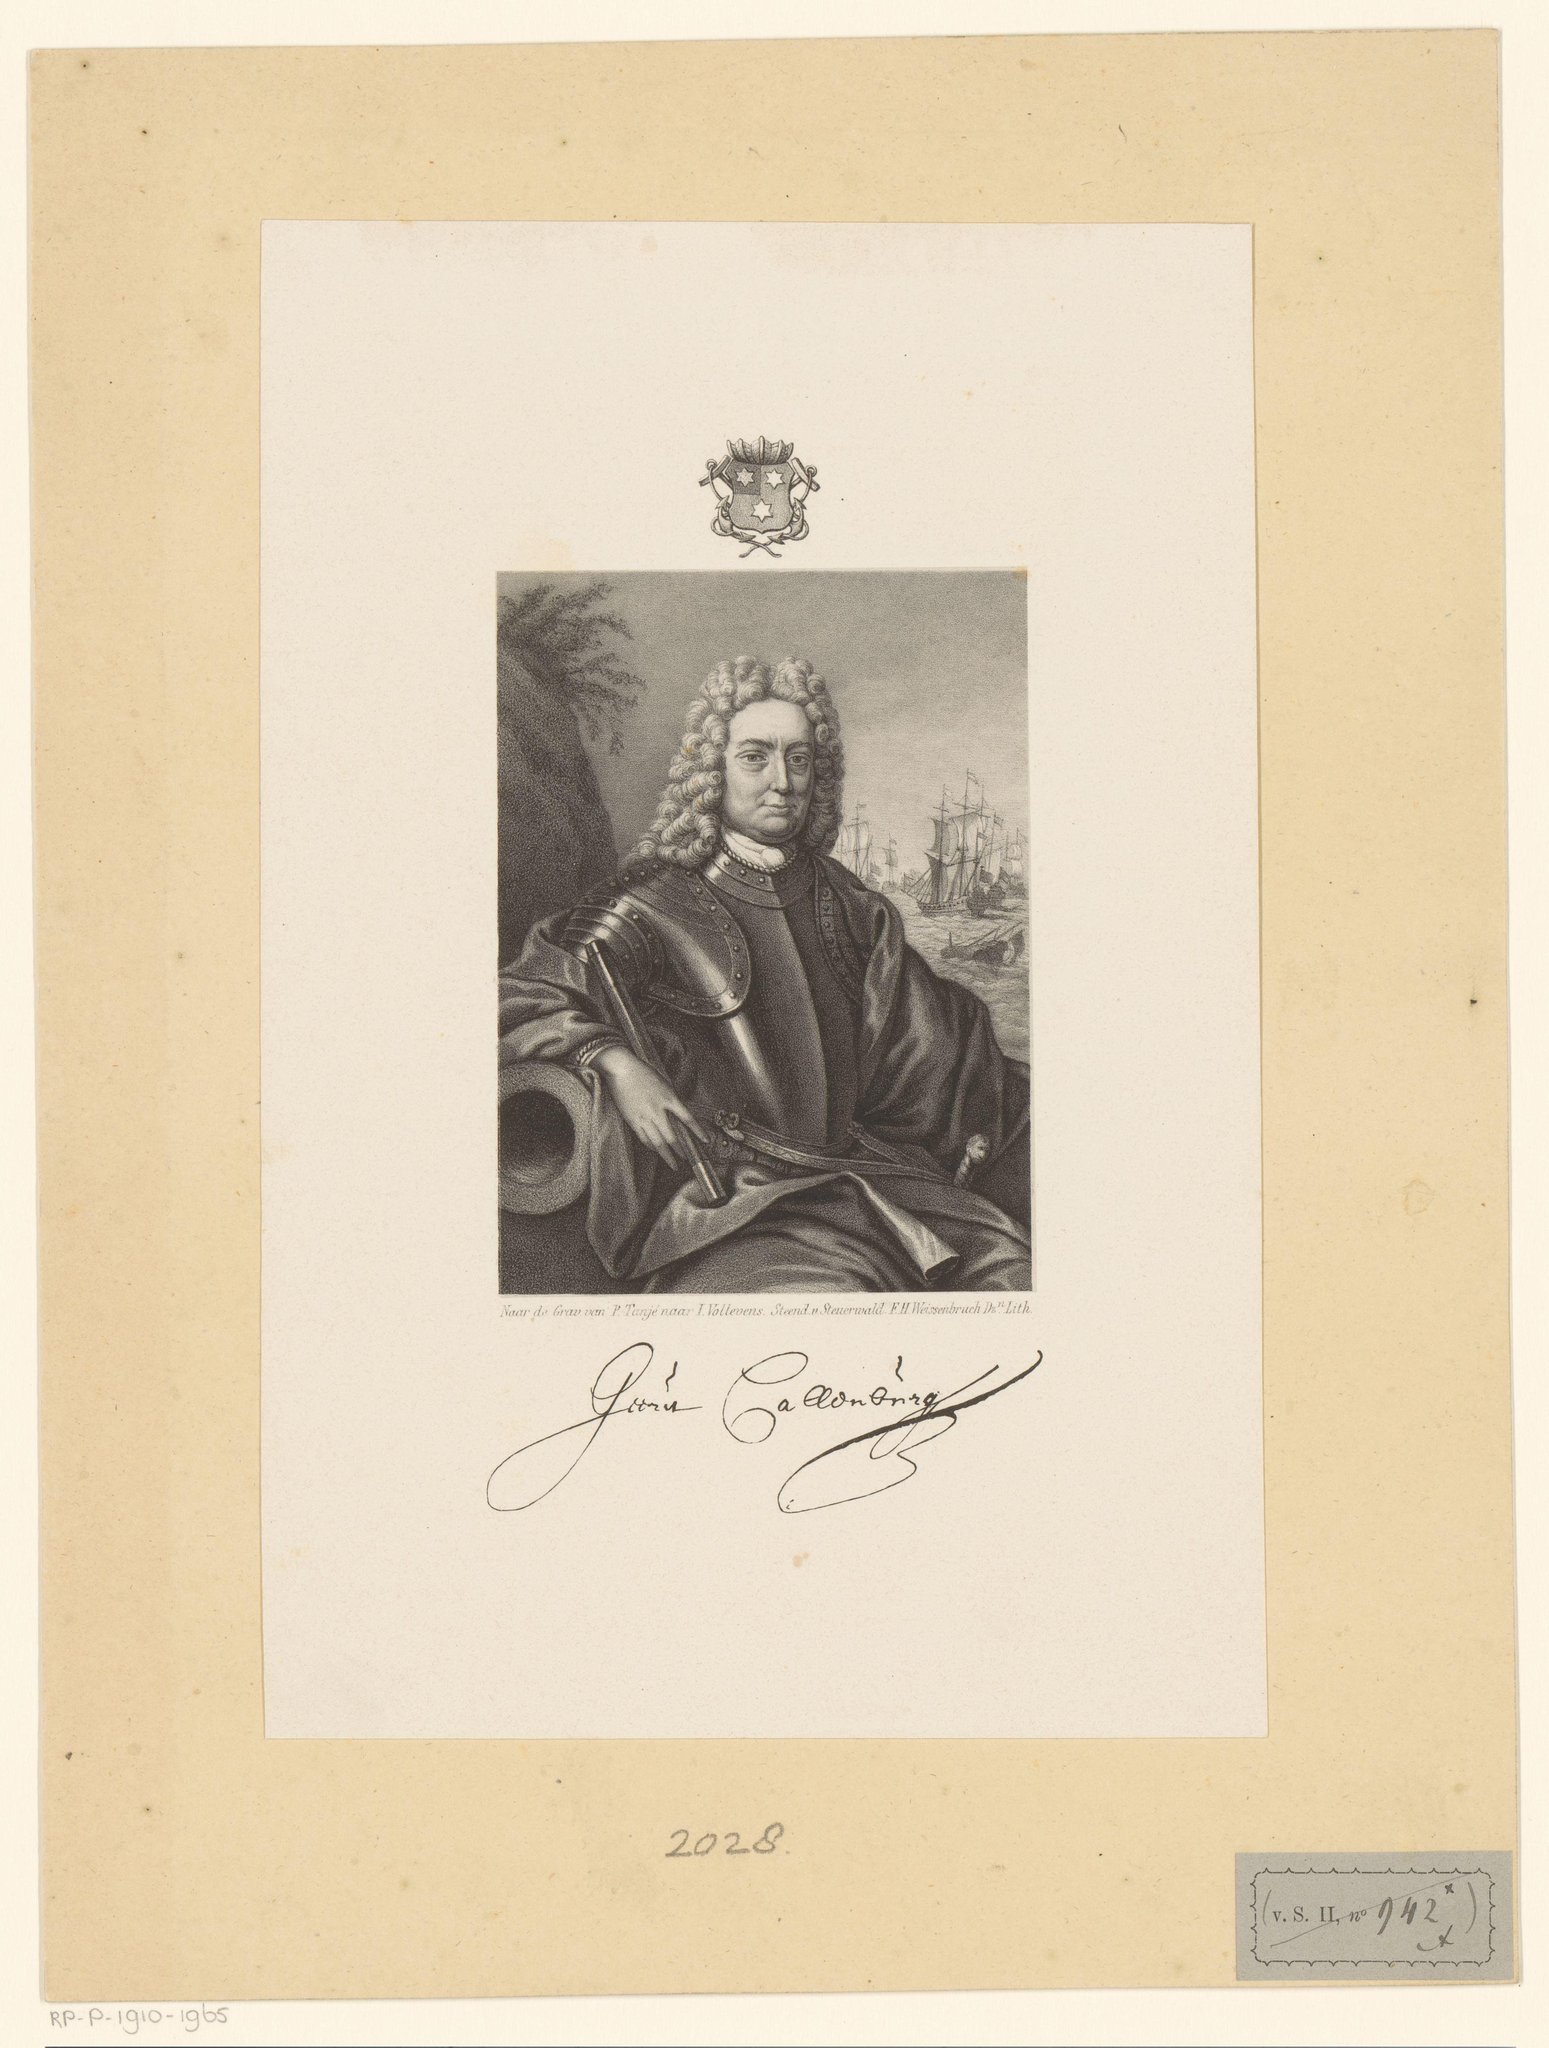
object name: book illustration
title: Portret van Gerard Callenburgh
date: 1858-1862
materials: paper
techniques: lithograph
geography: the hague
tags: flushing, gerard callenburgh, historical persons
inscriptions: collector's mark: Lugt 2228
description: Prent uit: Jonge, J.C. de. Geschiedenis van het Nederlandsche zeewezen. Haarlem: Jonge, J.K.J. de, 1858-62.